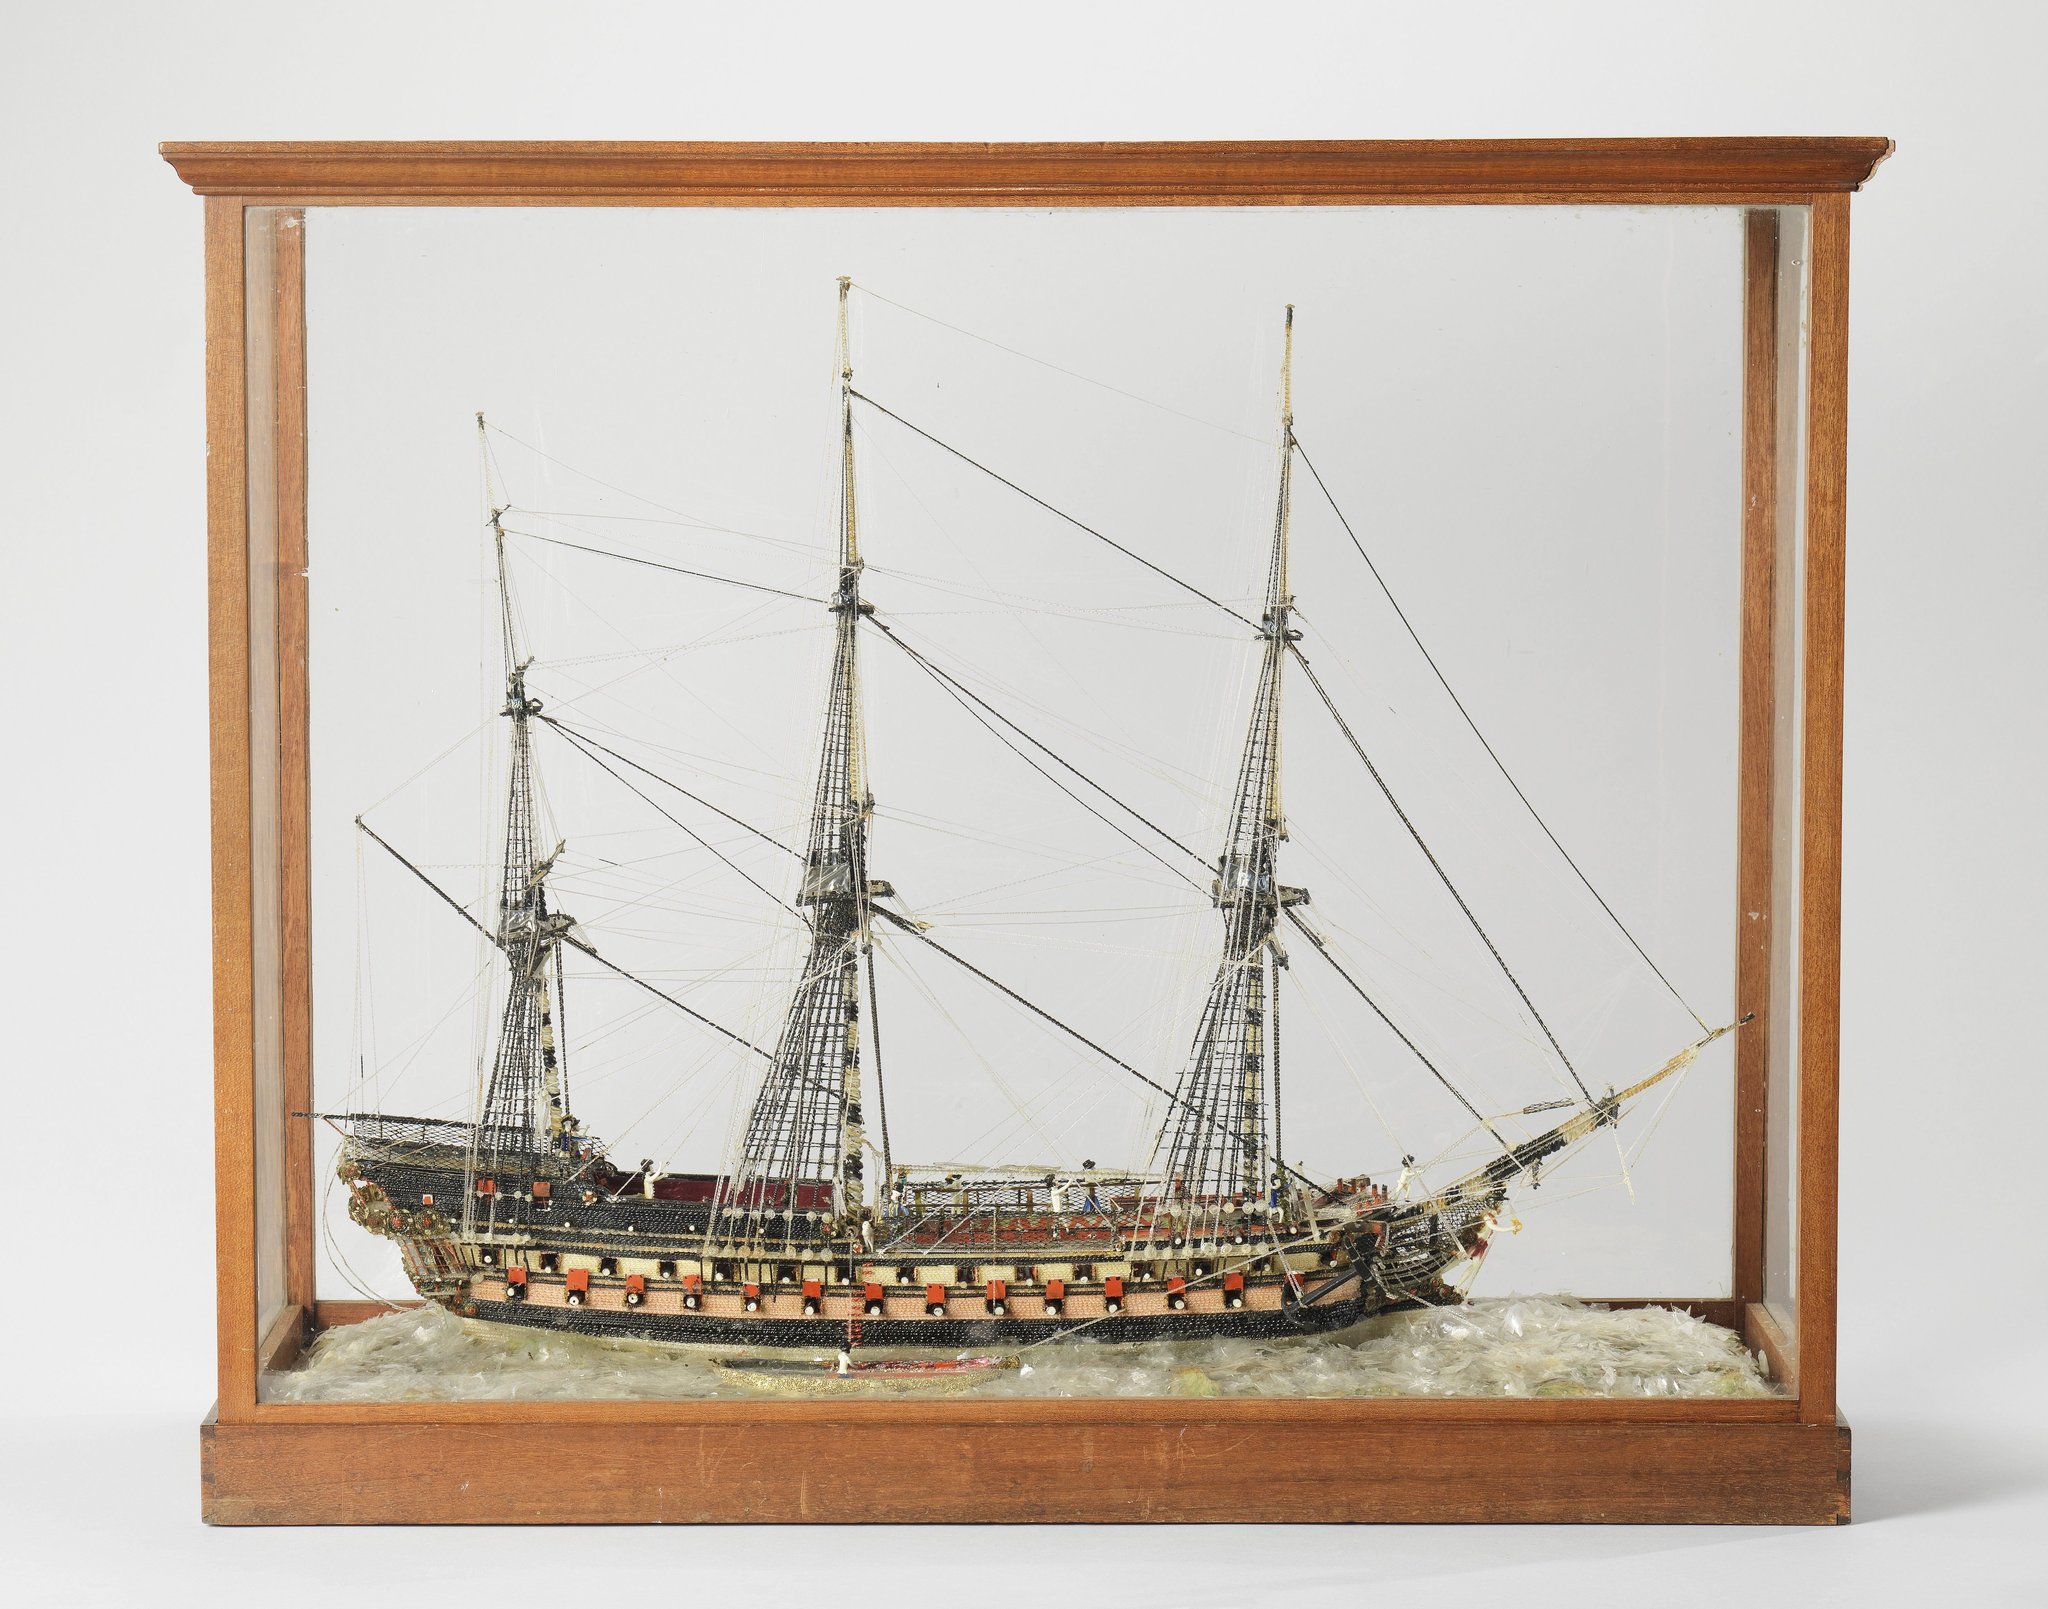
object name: show model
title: Glass Model of a 76-Gun Ship of the Line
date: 1770-1820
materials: glass, gold leaf, silver, wood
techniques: glassblowing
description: Volmodel van een linieschip, driemaster, met 76 stukken tot op de waterlijn. De drie masten en de boegspriet bestaan uit dikke gedraaide glazen draad. Het schip is verder opgebouwd uit enkele en zonodig meerdere dunnen glazen draden naast elkaar. De draden zijn zwart of kleurloos en bijna allemaal gedraaid. Aan boord negen figuren in verschillende gekleurde kleding, en een hond. Als boegbeeld een mannenfiguur met steekwapen in de rechterhand. Aan beide zijden van het schip een sloep. Het model staat in houten kast. De zee is weergegeven met glasschilfers.